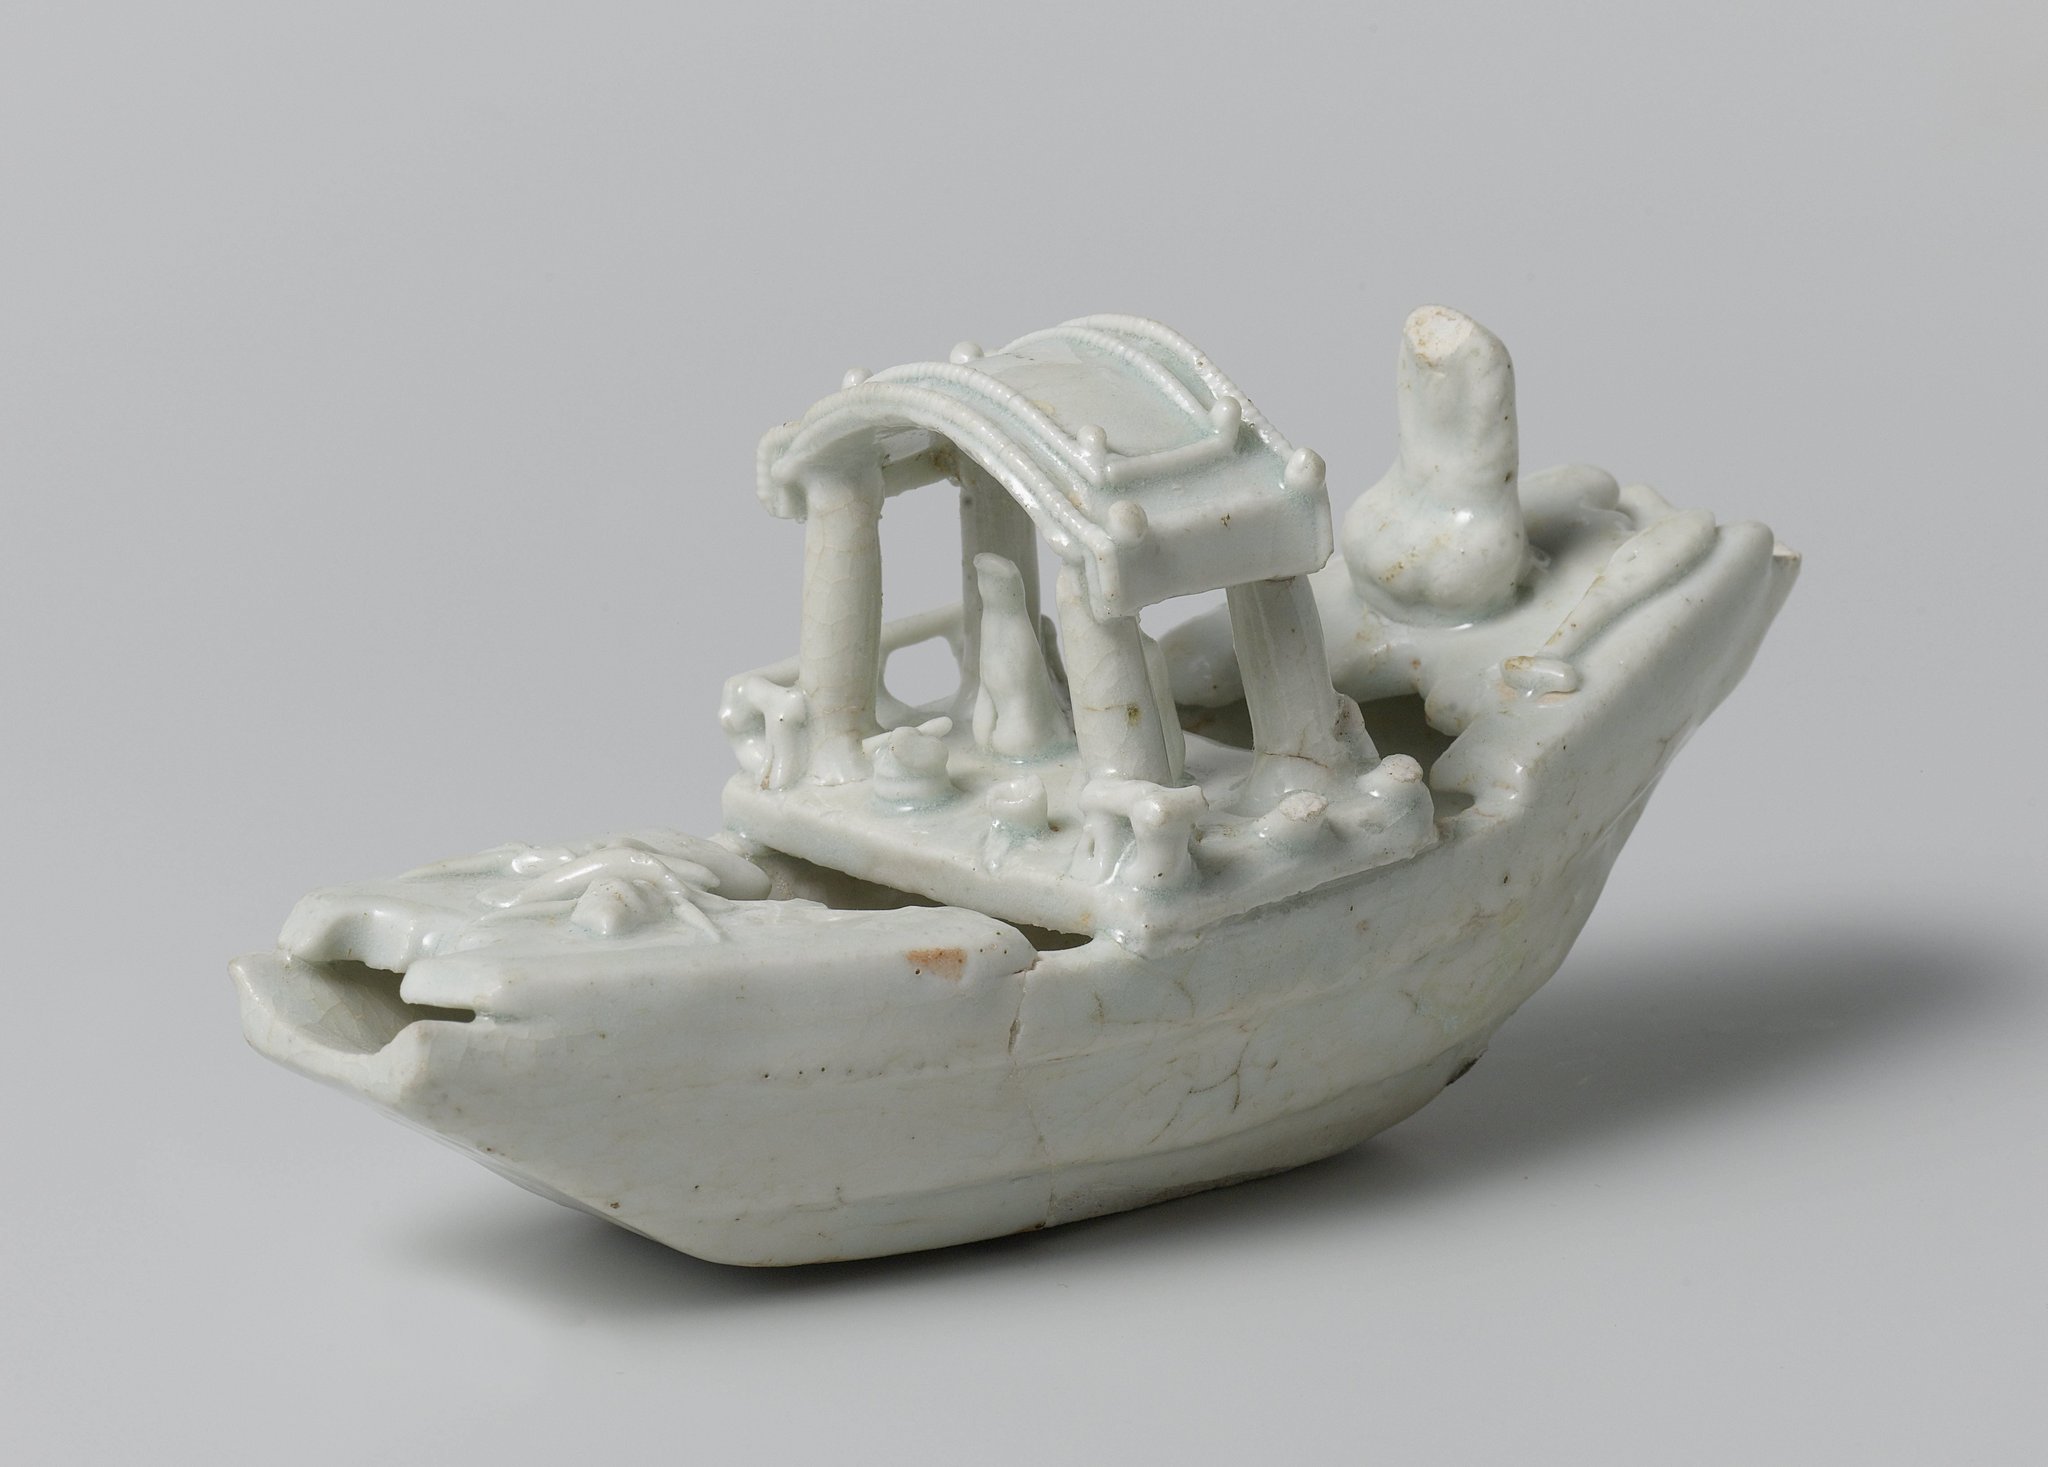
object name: figure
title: Boat with three figures and objects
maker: Anonymous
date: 1279-1368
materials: glaze, stoneware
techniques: firing, forming, vitrification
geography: china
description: Even though the head of the main figure is missing, it can be deduced from this motif that this is Guanyin and his/her servants Shancai and Longnu. They are sitting in a boat, a symbol of rescue; Guanyin saves people at risk of drowning in a sea of misfortune.